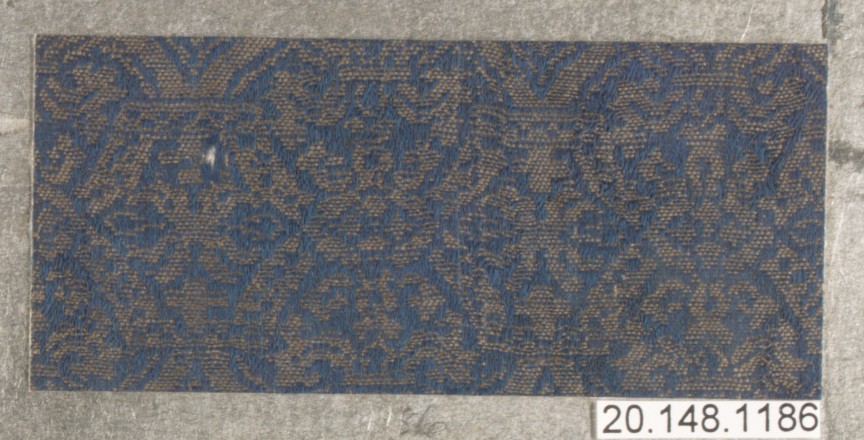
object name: piece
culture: japanese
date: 1701-1800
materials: silk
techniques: compound weave